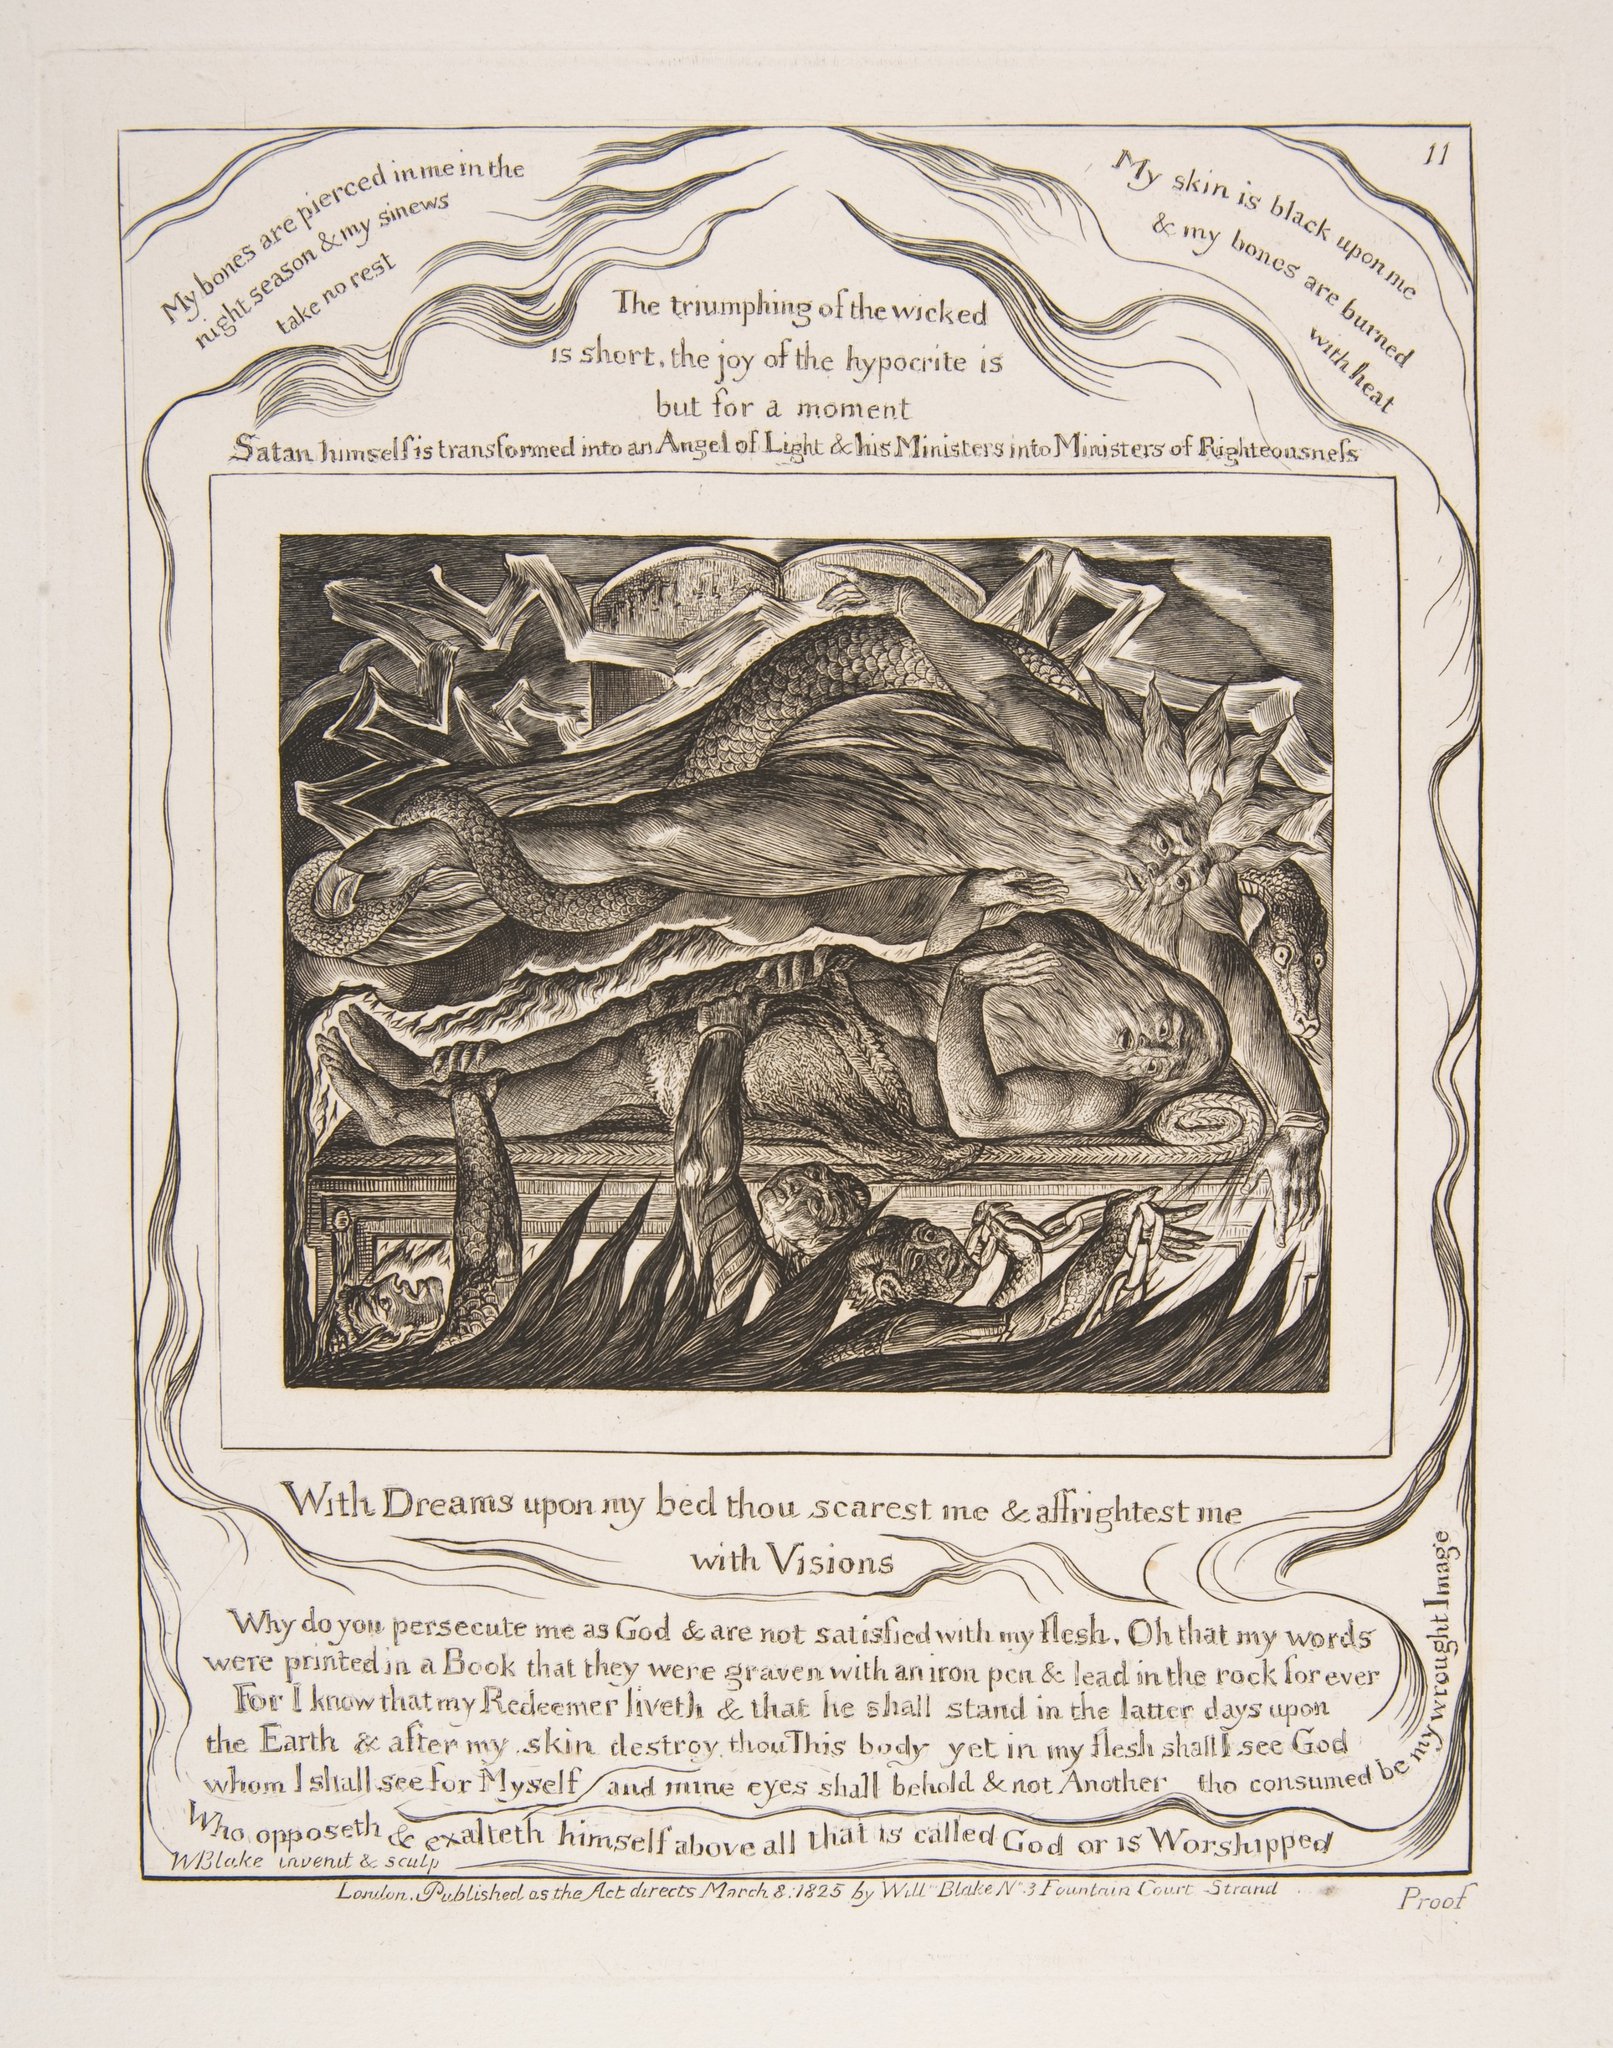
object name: print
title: Job's Evil Dreams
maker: william blake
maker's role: artist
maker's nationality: british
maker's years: 1757-1827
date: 1825-1826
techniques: engraving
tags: men,snakes